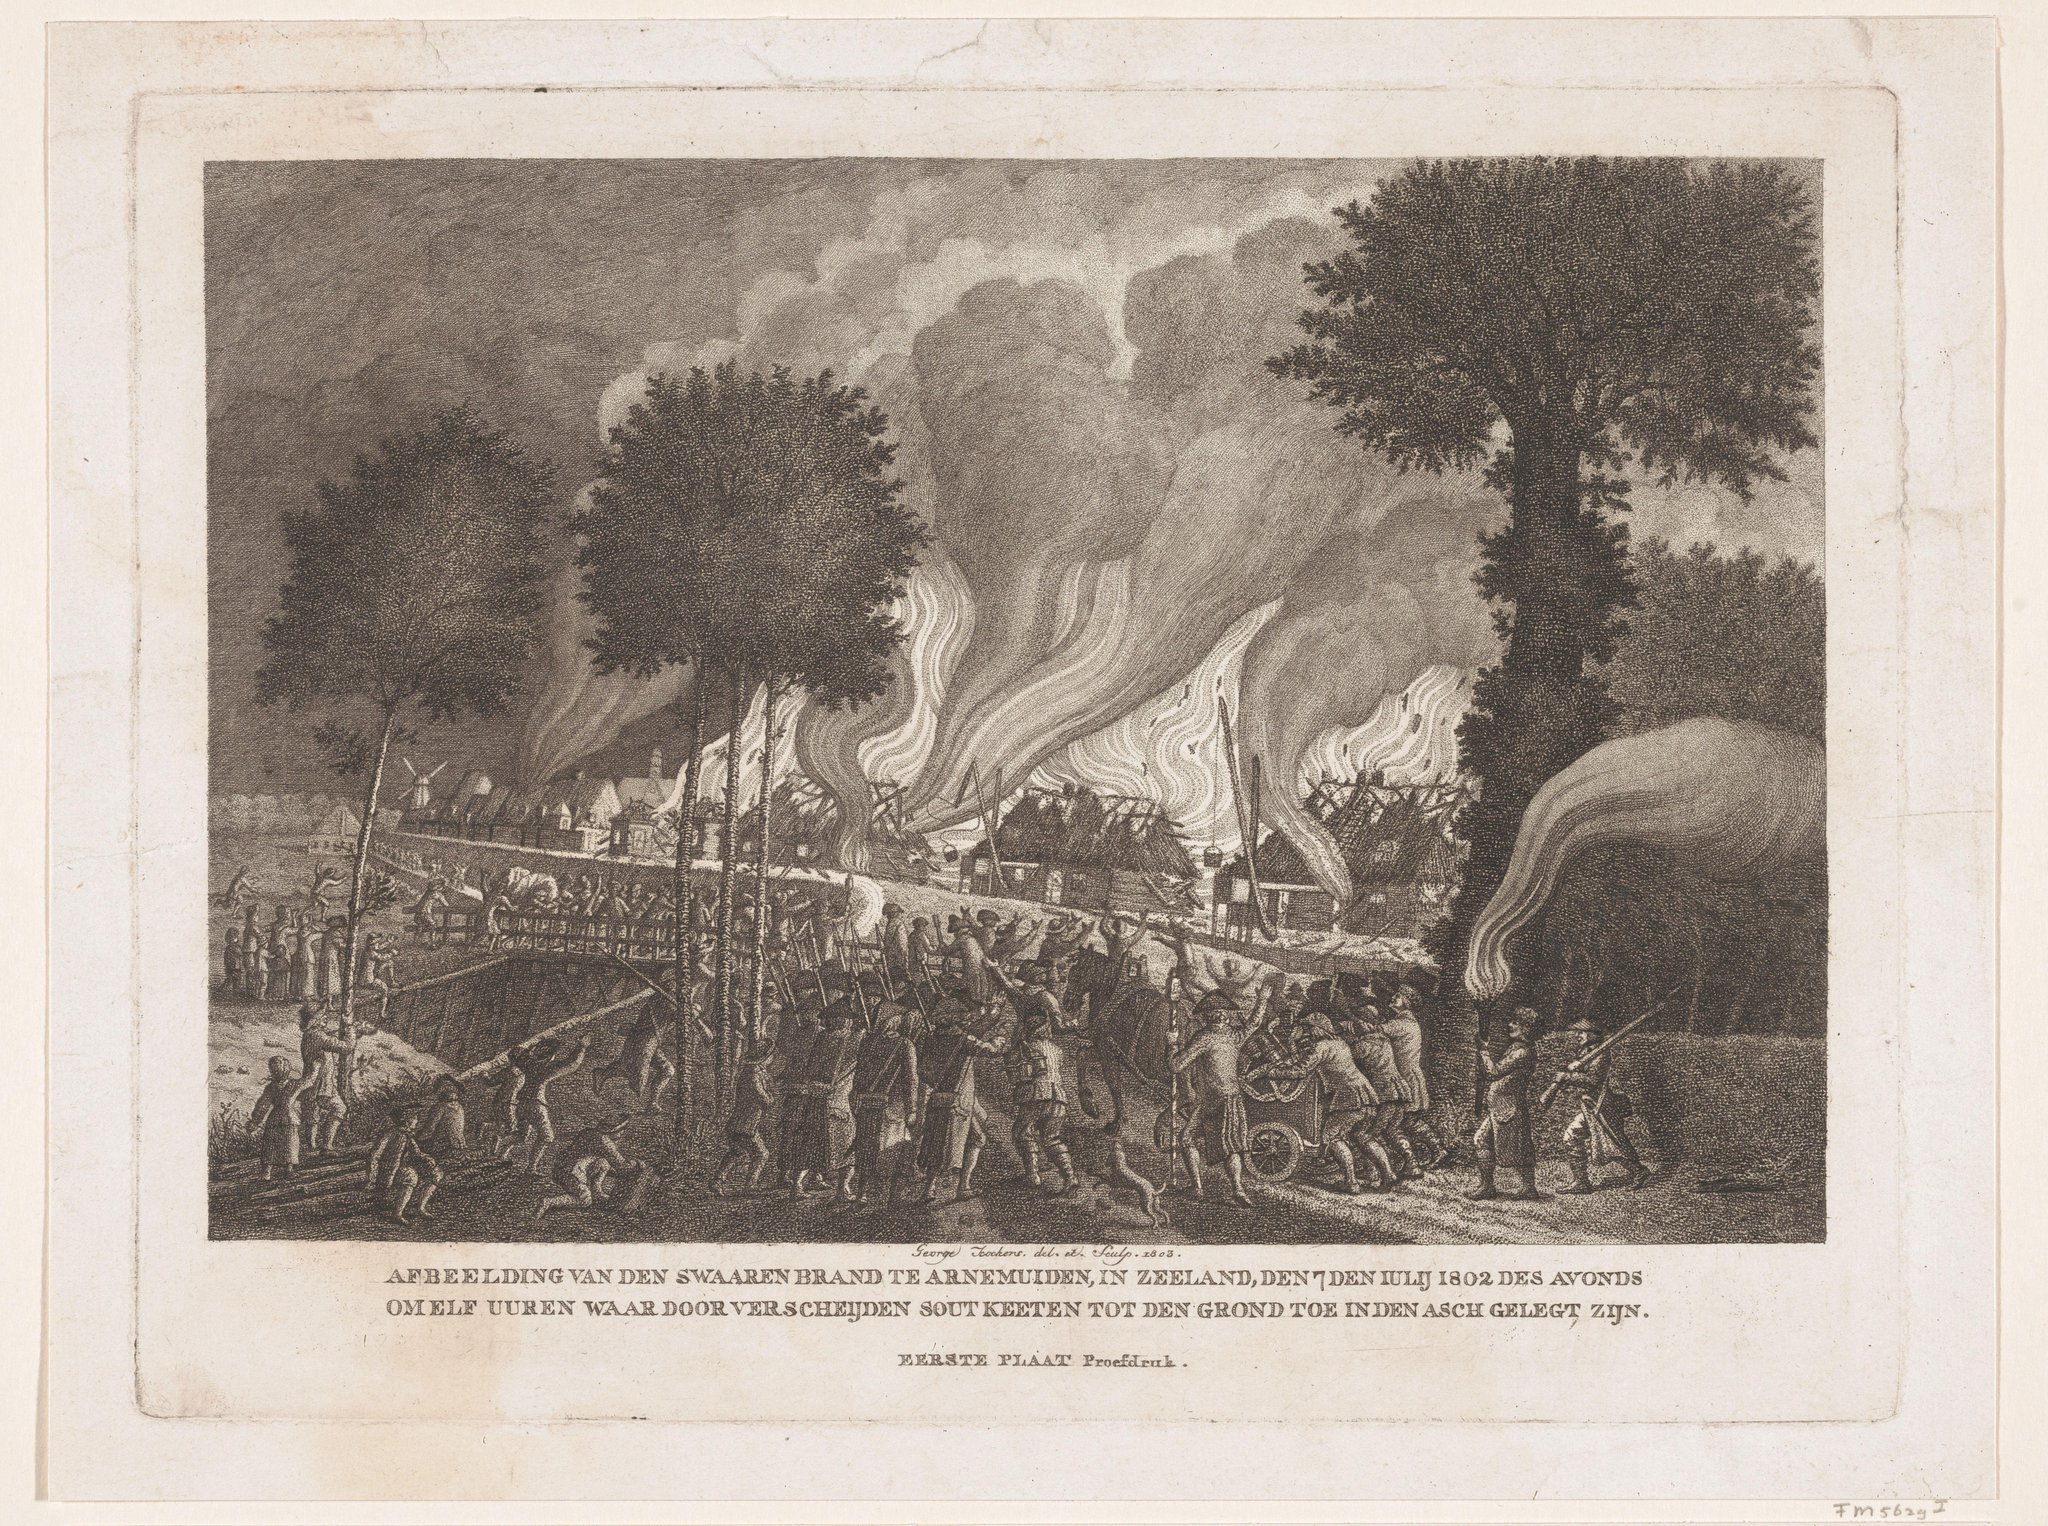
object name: print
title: Afbeelding van den Swaaren Brand te Arnemuiden, in Zeeland, den 7den Iulij 1802 des avonds om elf uuren waardoor verscheijden Soutkeeten tot den grond toe in den asch gelegt zijn.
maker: george kockers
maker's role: goldsmith, print maker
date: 1803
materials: paper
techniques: engraving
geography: netherlands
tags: on fire, ablaze, pump (fire-extinguishing equipment)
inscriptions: collector's mark: Lugt 2228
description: Grote brand in Arnemuiden op 7 juli 1802 waarbij verschillende zoutketen zijn afgebrand. De brandweer komt met een brandspuit aangereden. Menigte toeschouwers bij de brandende gebouwen. Zie ook de pendant.